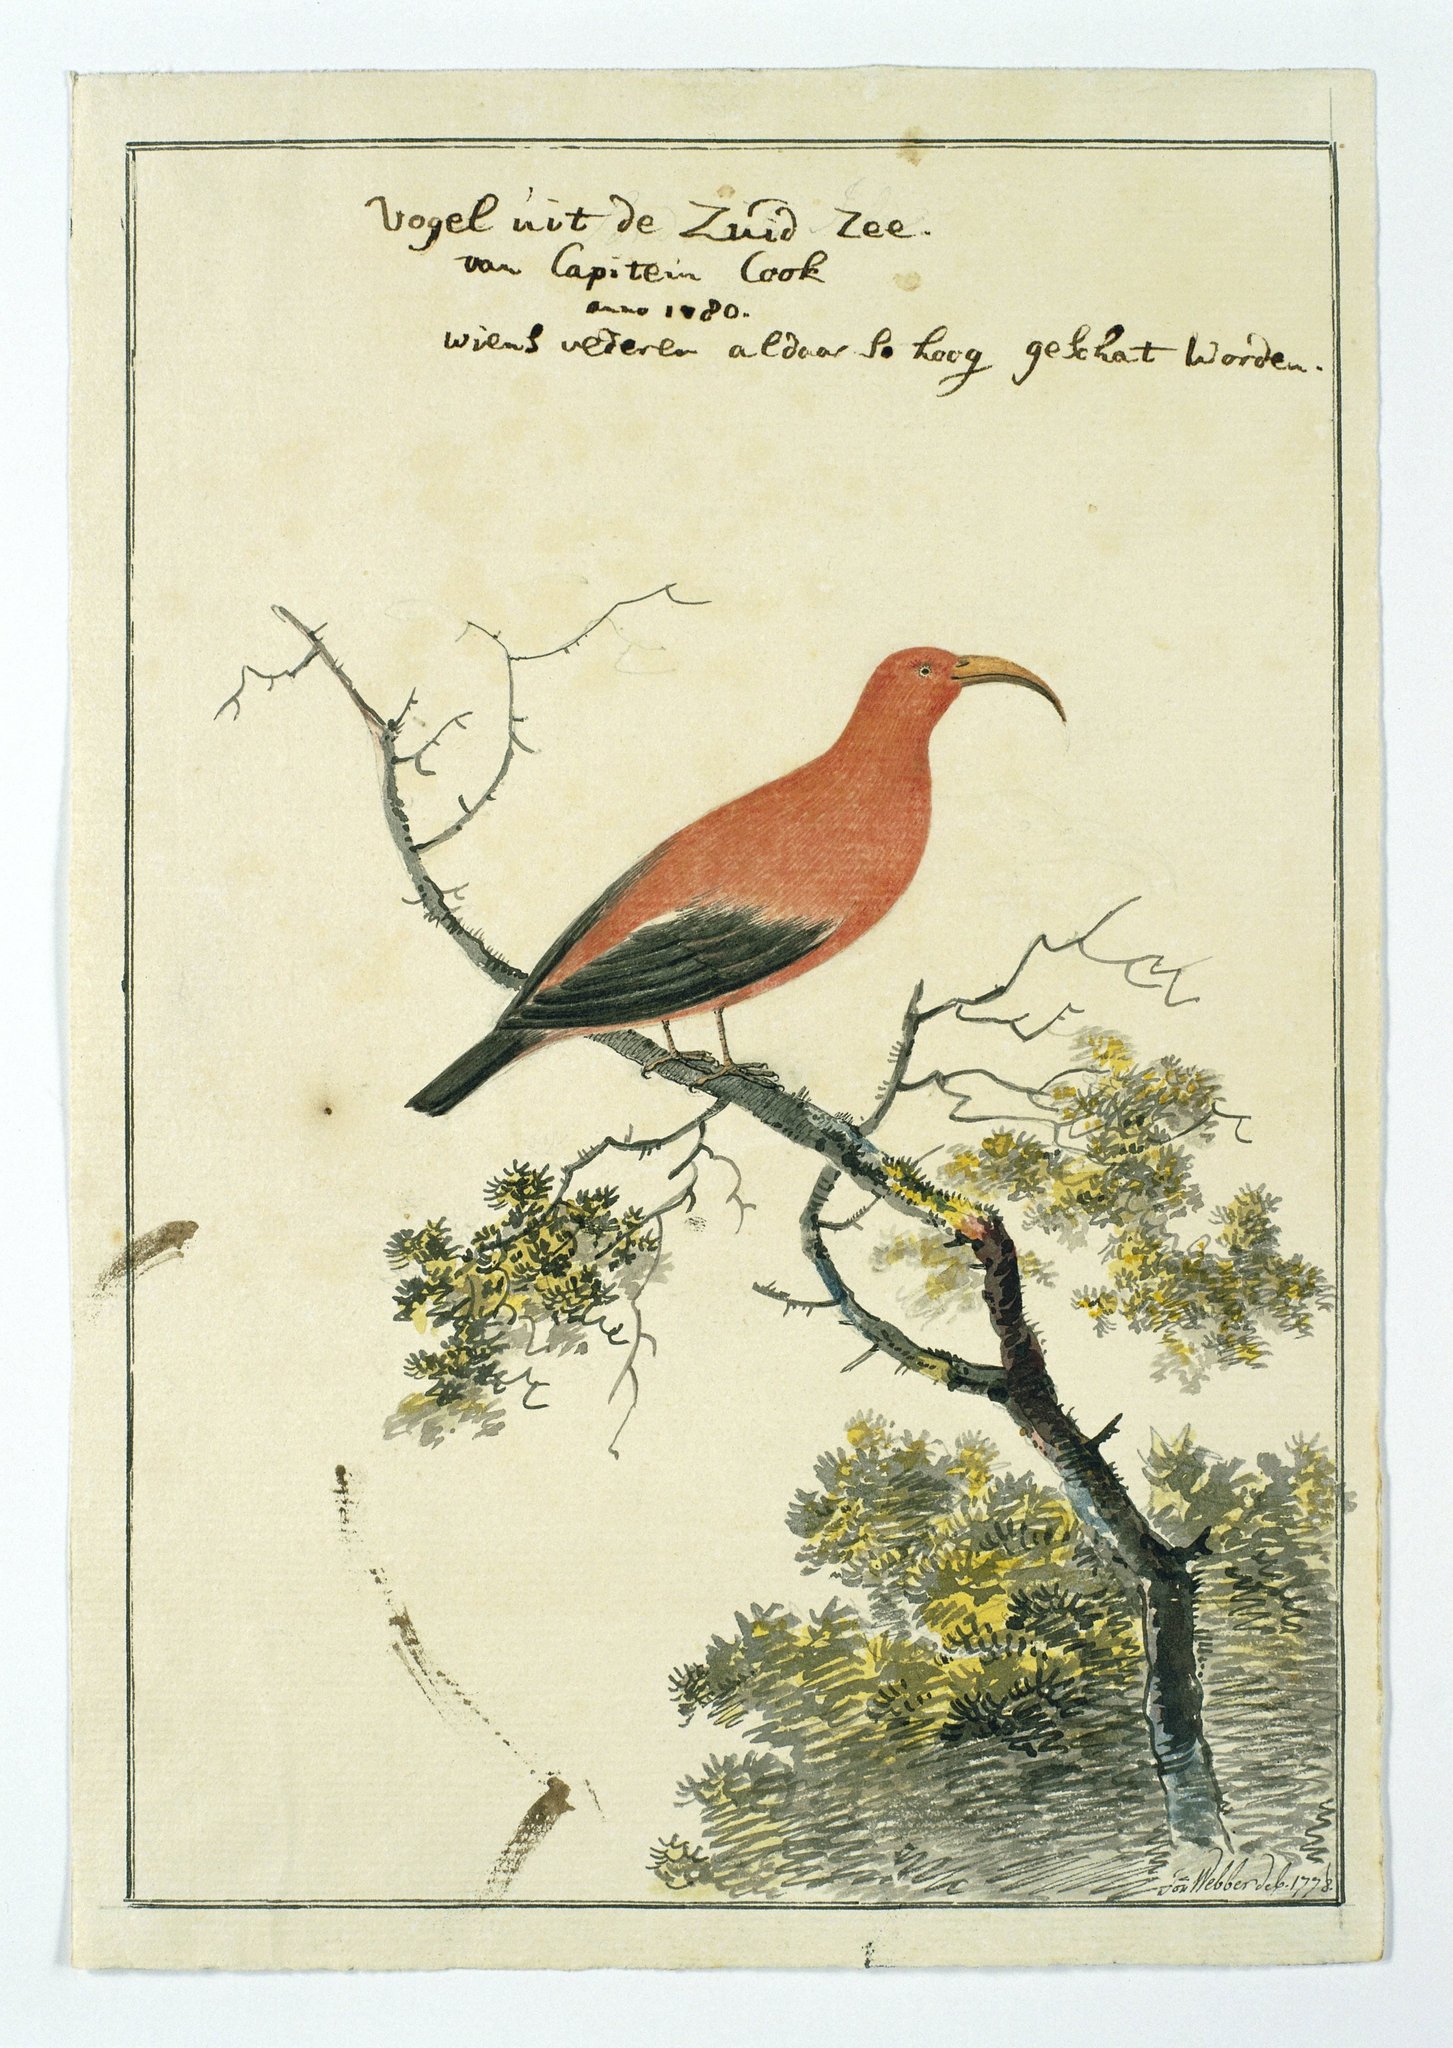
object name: album leaf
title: Vestiaria coccinea (Iiwi or Scarlet Hawaiian honeycreeper)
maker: john webber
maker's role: draughtsman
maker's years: 1750-1793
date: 1778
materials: chalk, ink, paper, pencil, watercolor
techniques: brush, pen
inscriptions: signature and date: ‘Jon Webber del. 1778’, annotation: ‘Vogel uit de Zuid Zee. / van Capitein Cook / anno 1780. / wiens vederen aldaar So hoog geschat Worden. op verso: uit de Zuidzee / door Capt Cook.’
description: De Kardinaalhoningeter komt niet voor in Zuidelijk Afrika; waarschijnlijk aan Gordon geschonken door James Cook, tijdens zijn bezoek aan de Kaap in 1780. John Webber begeleidde 'Captain Cook' op zijn derde ontdekkingsreis door de Zuidzee.